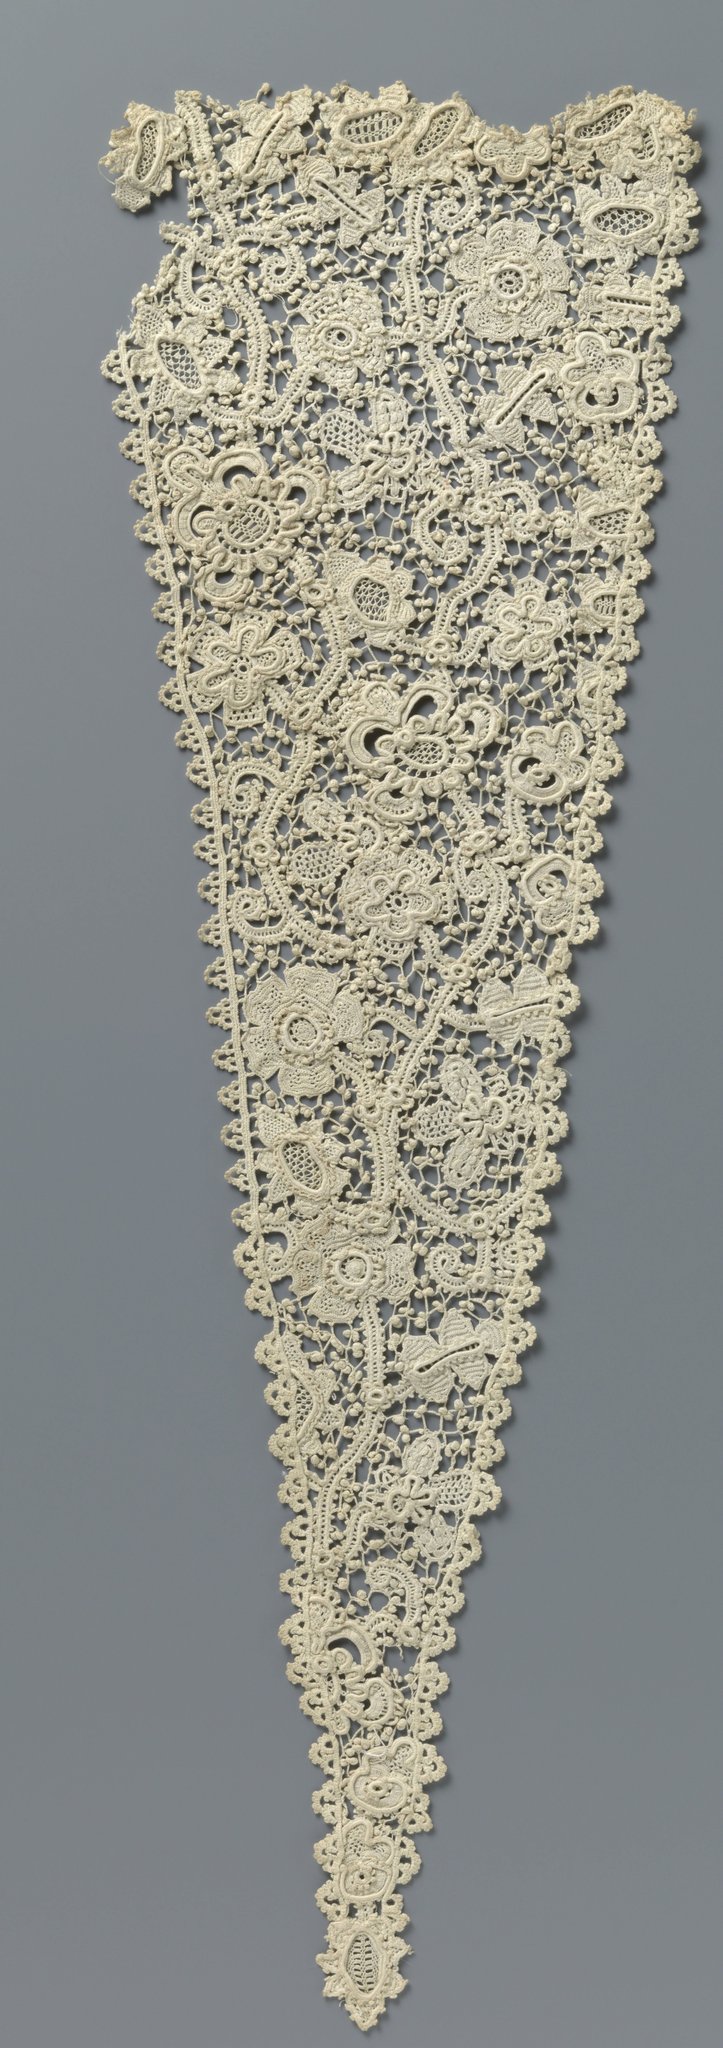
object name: oplegstuk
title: Oplegstuk van gehaakte kant imitatie grove Venetiaanse kant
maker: Anonymous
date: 1890-1909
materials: cotton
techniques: crocheted lace, irish crochet lace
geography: ireland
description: Het is een aanname dat deze Ierse gehaakte kant ook daadwerkelijk in Ierland is gemaakt. Ierse gehaakte kant kent zijn oorsprong rond 1760 en kwam vanaf 1840 in ontwikkeling. Aangezien volgens Martine Bruggeman (Kant in Europa) de Ierse haakindustrie aan het eind van de 19e eeuw gereorganiseerd werd en in populariteit groeide, is het hier beschreven stuk gedateerd rond 1890, tot 1909 vanwege de datering in het eerste decennium van populariteit van Ierse gehaakte kant volgens het Kantlexicon (Johan Coene).